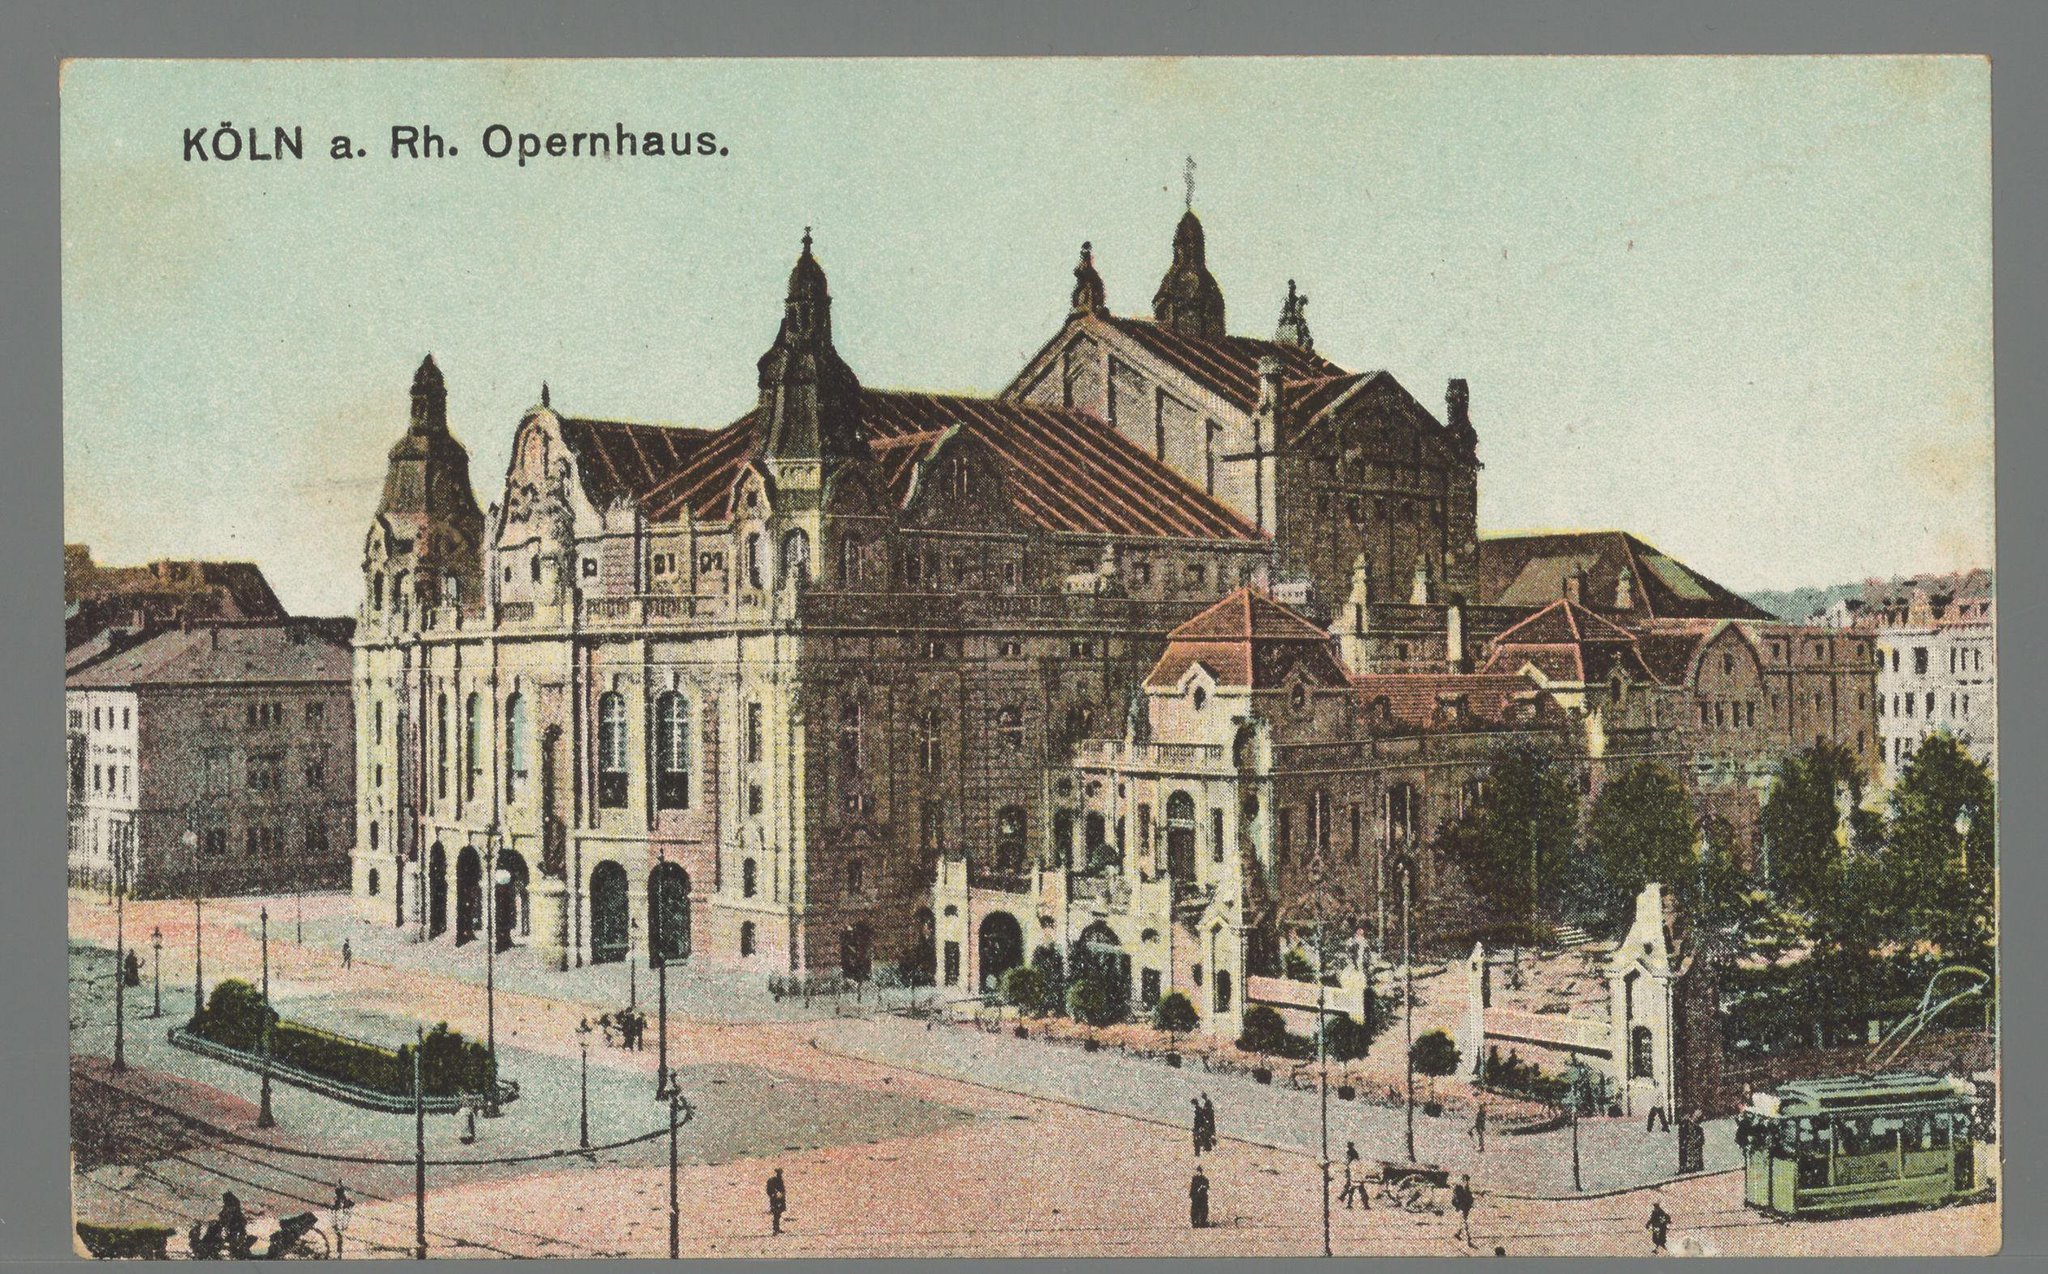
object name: photomechanical print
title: Köln a. Rh. Opernhaus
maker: Anonymous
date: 1905-1930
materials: cardboard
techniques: lithograph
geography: cologne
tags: opera house, cologne